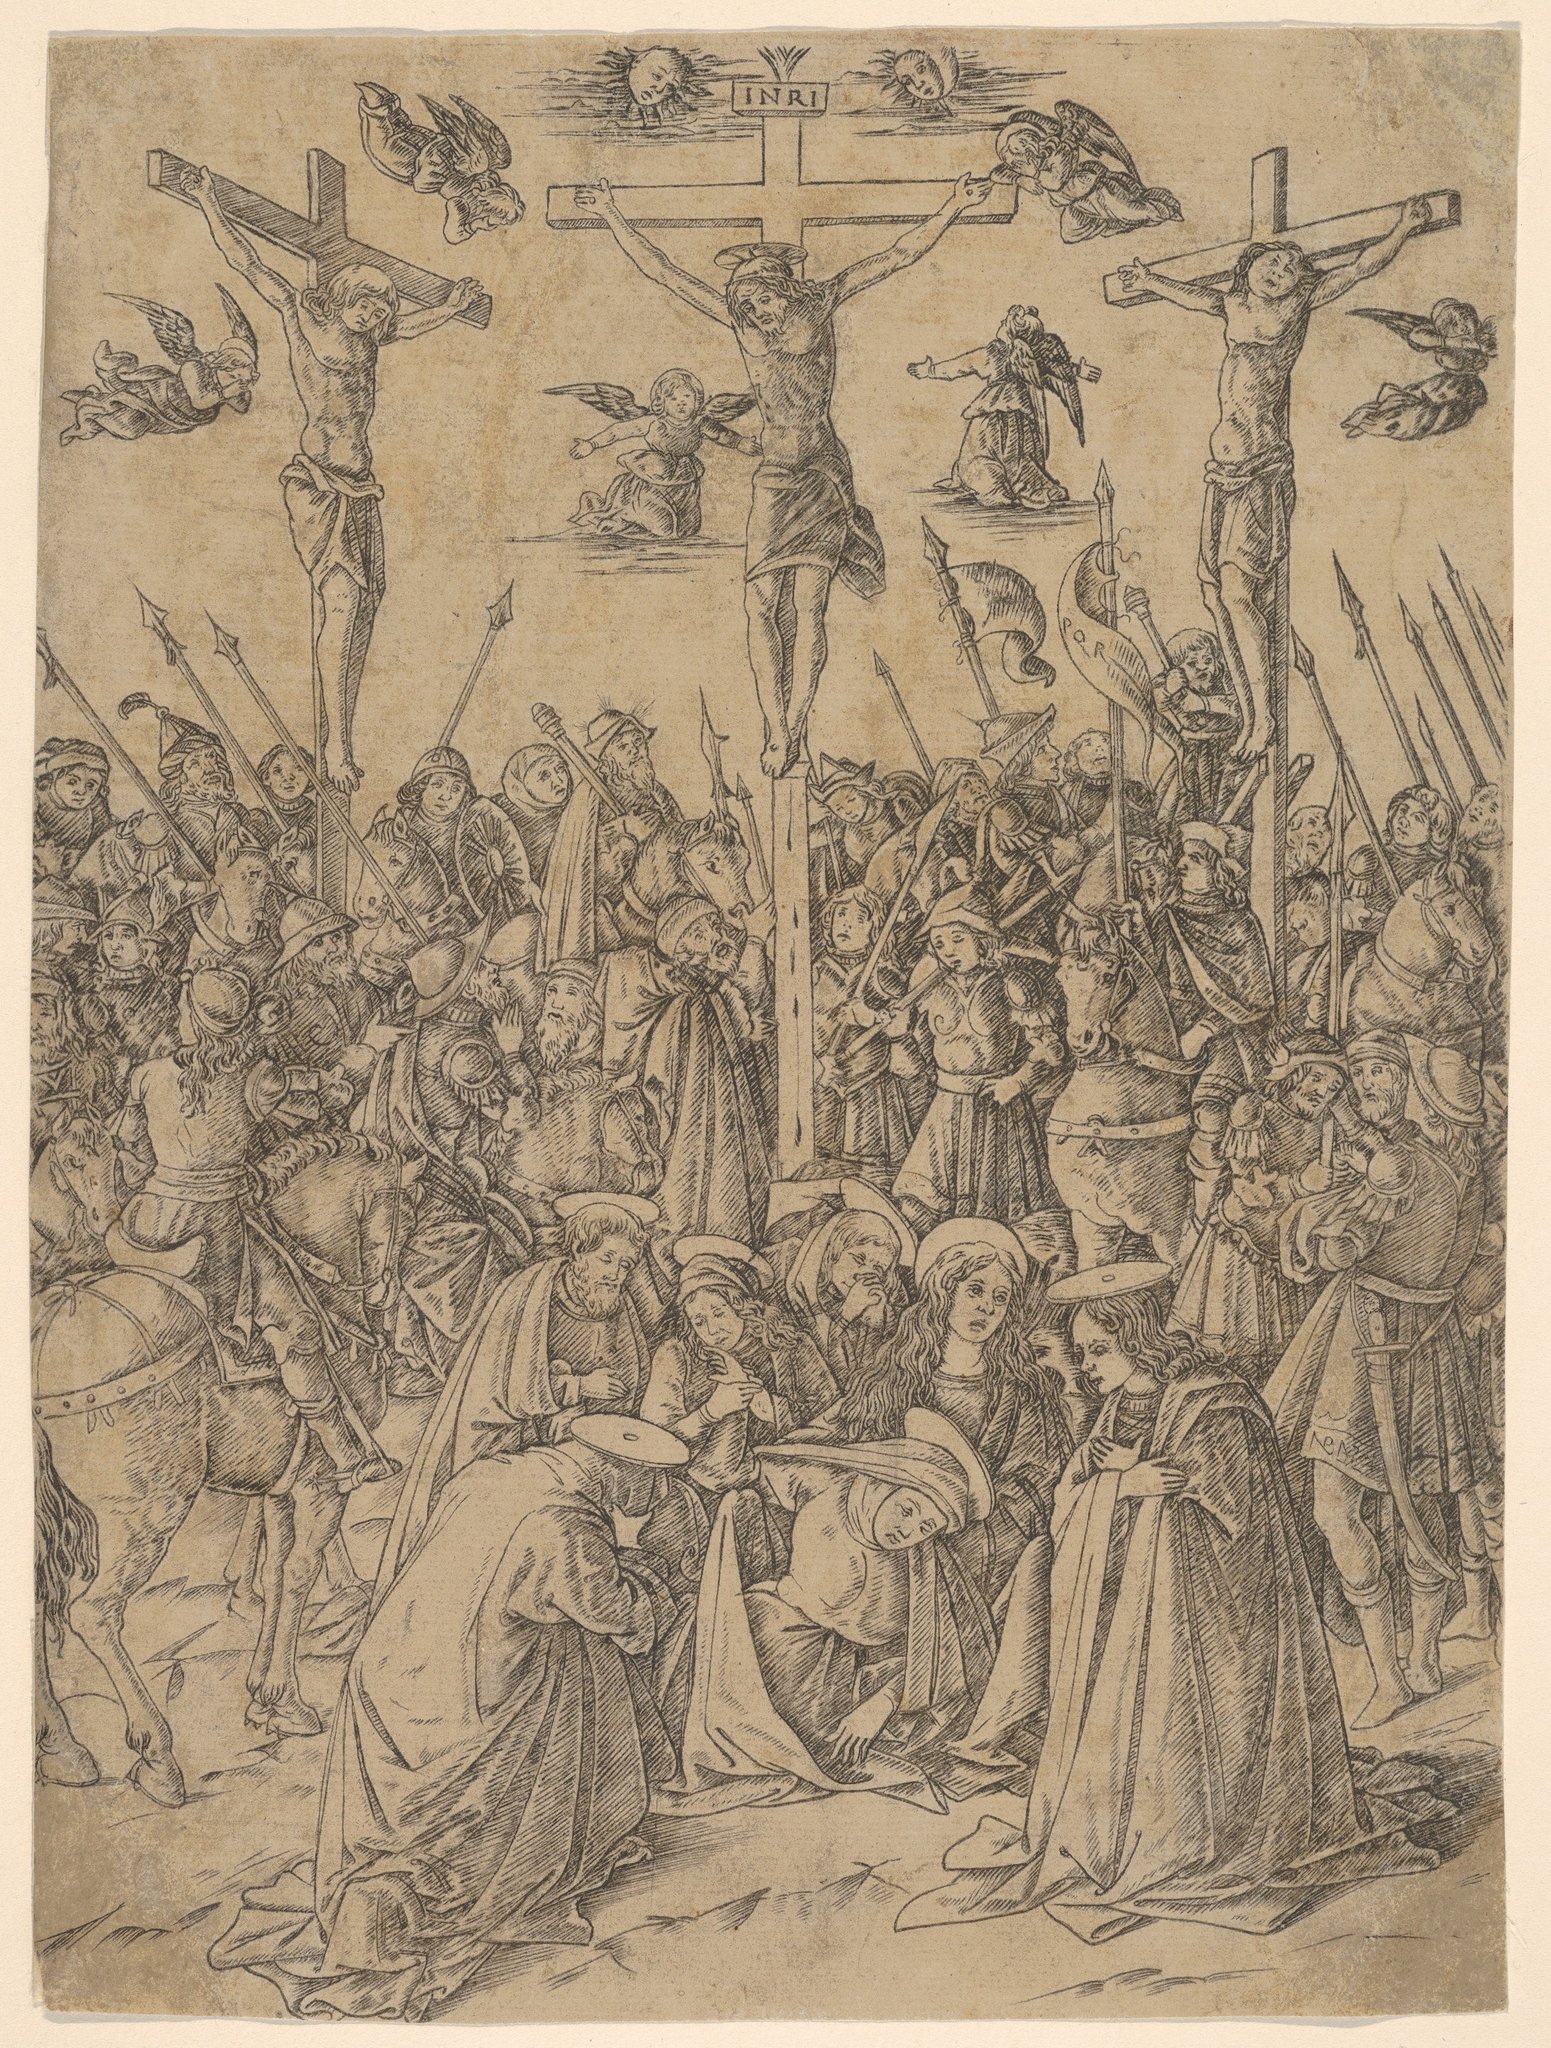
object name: print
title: Calvary, from Life of the Virgin and Christ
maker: francesco rosselli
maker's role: artist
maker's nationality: italian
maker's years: 1448-1527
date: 1490-1500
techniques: engraving, hand coloring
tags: angels,christ,virgin mary,crucifixion,crowd